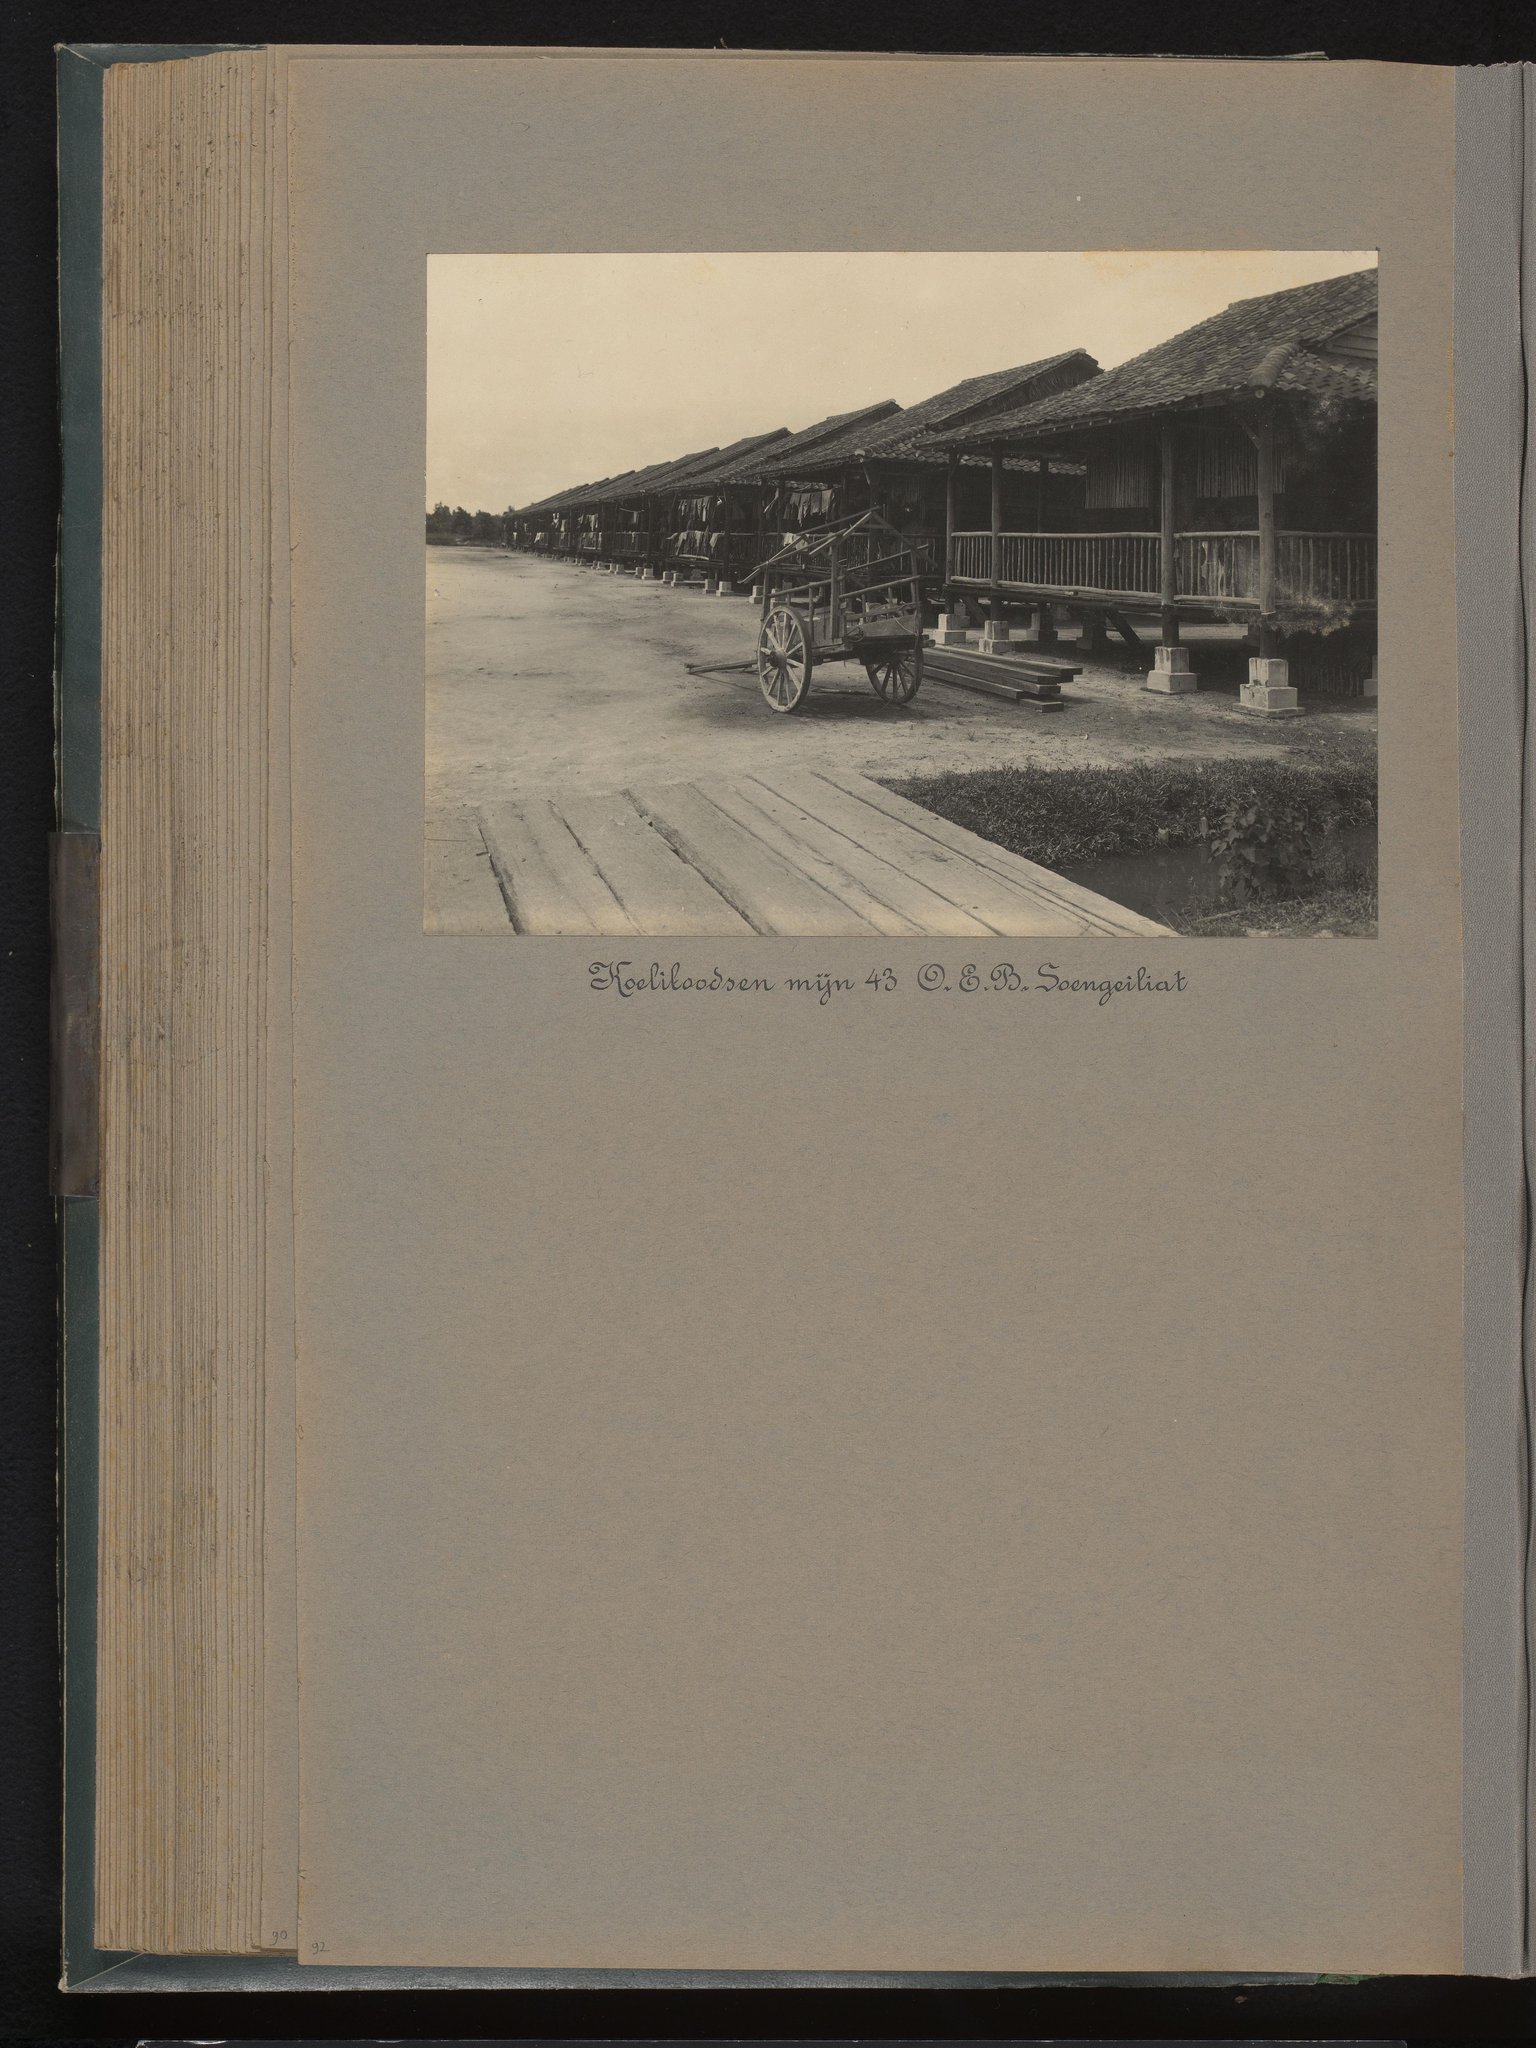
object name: photograph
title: Woningen voor contractarbeiders bij een tinmijn in Soengeiliat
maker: Anonymous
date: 1914-1919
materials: photographic support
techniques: gelatin silver print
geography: bangka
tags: robert julius boers, colonial system, mining, working class, labourers, hut, cabin, lodge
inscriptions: inscription: ‘Koelieloodsen in mijn 43 O.E.B. Soengeiliat’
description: Albumblad met 1 foto van woningen voor contractarbeiders bij een tinmijn in Soengeiliat. Onderdeel van het fotoalbum aangeboden aan Robert Julius Boers bij zijn vertrek naar Nederland in 1919 door het personeel van de Banka-tinwinning.